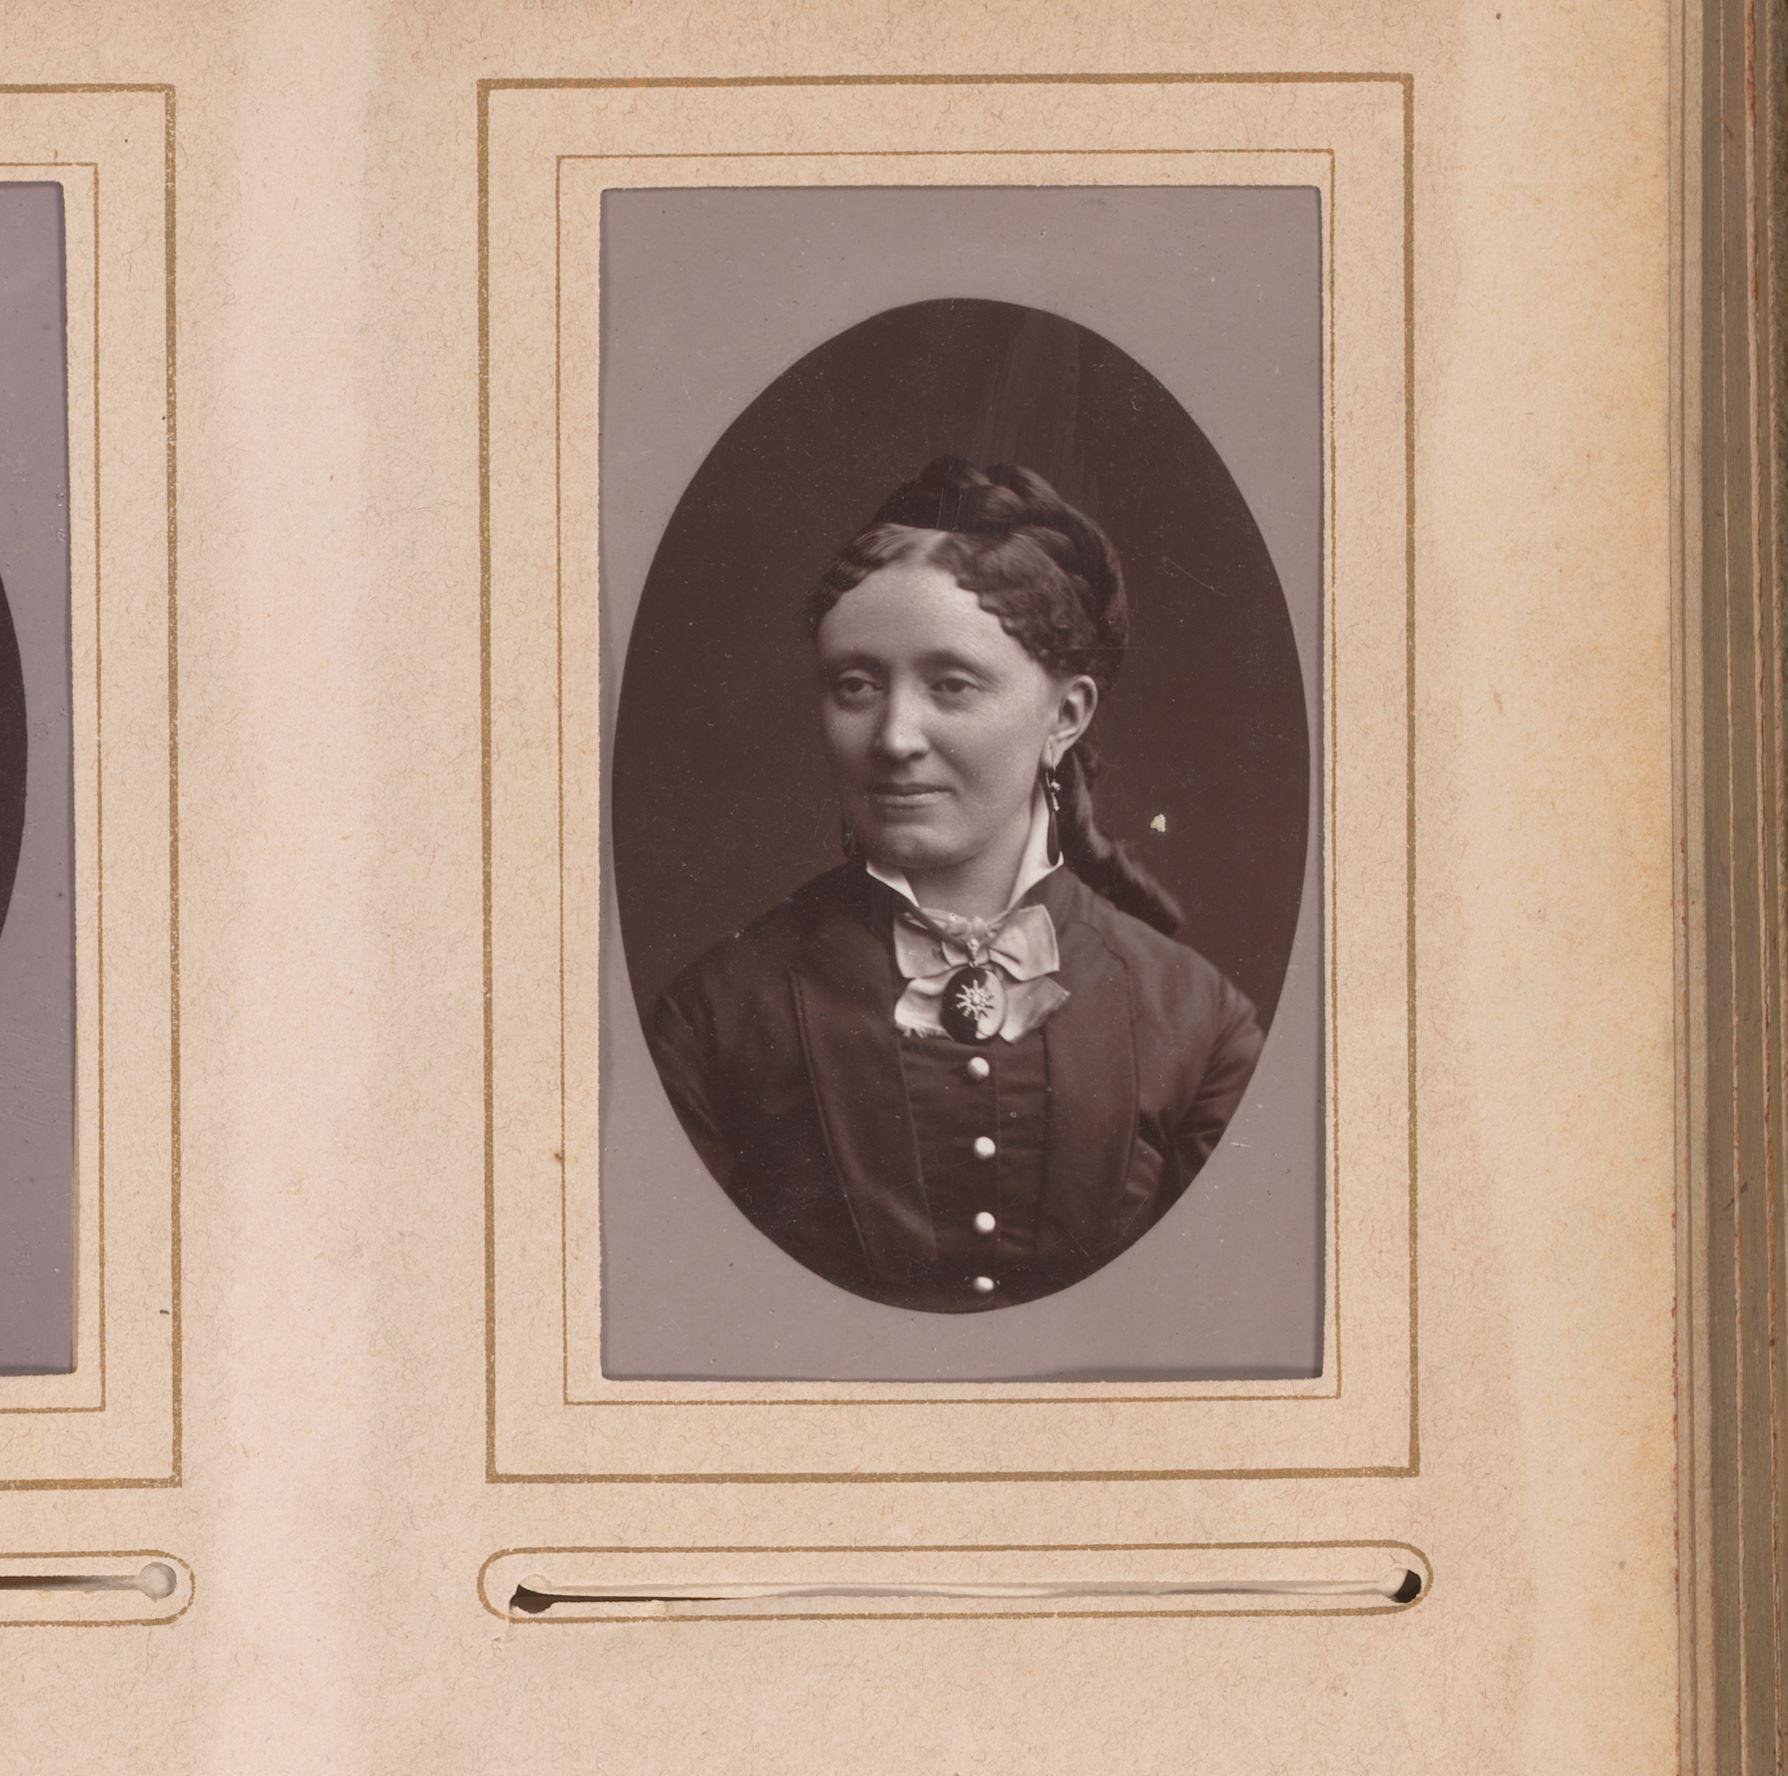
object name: photograph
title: Portret van een vrouw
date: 1872-1889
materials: cardboard, paper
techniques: carbon print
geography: ghent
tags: historical persons - bb - woman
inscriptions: inscription: ‘Beernaert Freres/ Gand/ Rue de la Vigne/ Hareng pec.’